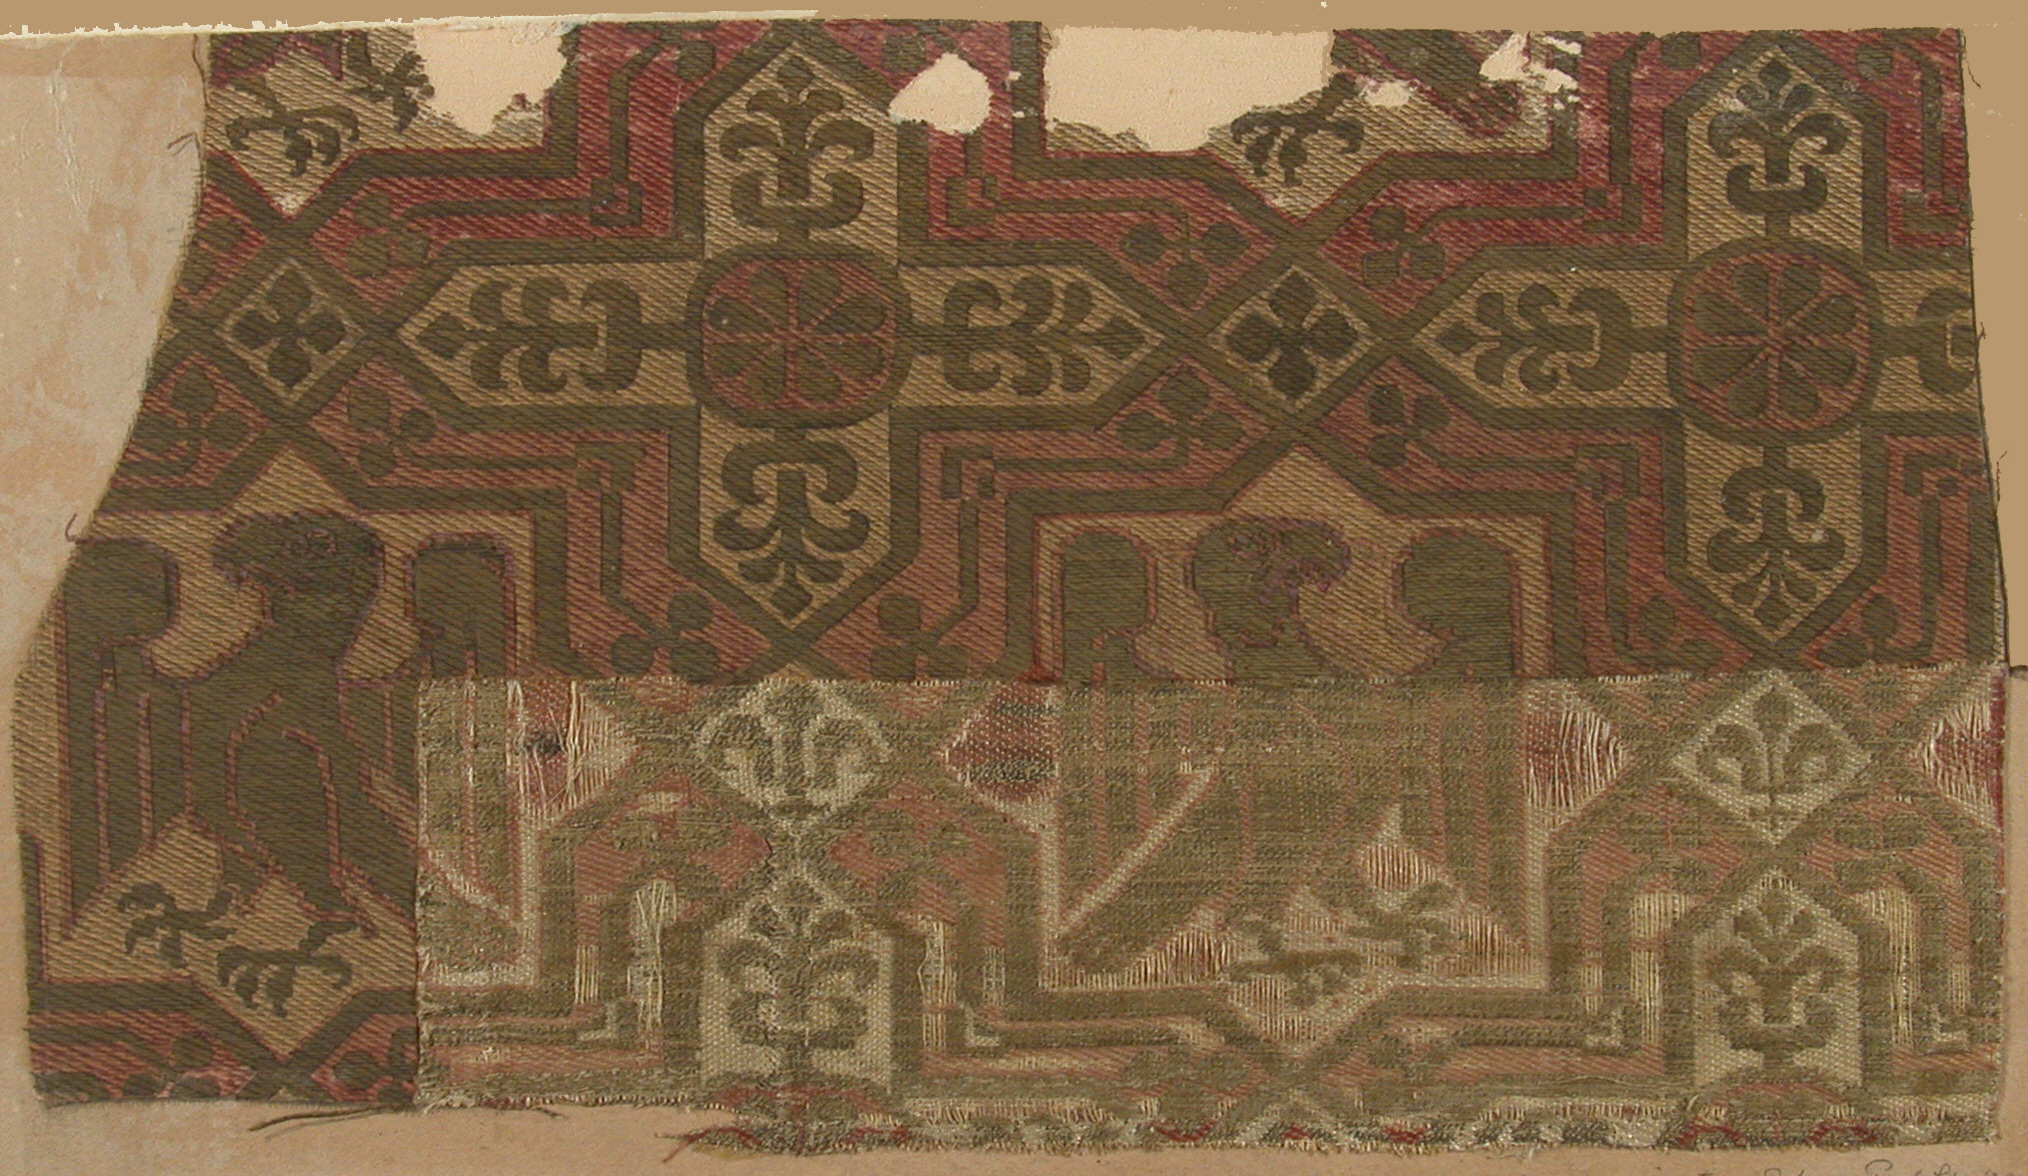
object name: textile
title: Brocade Textile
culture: italian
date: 1201-1300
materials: gold thread, silk